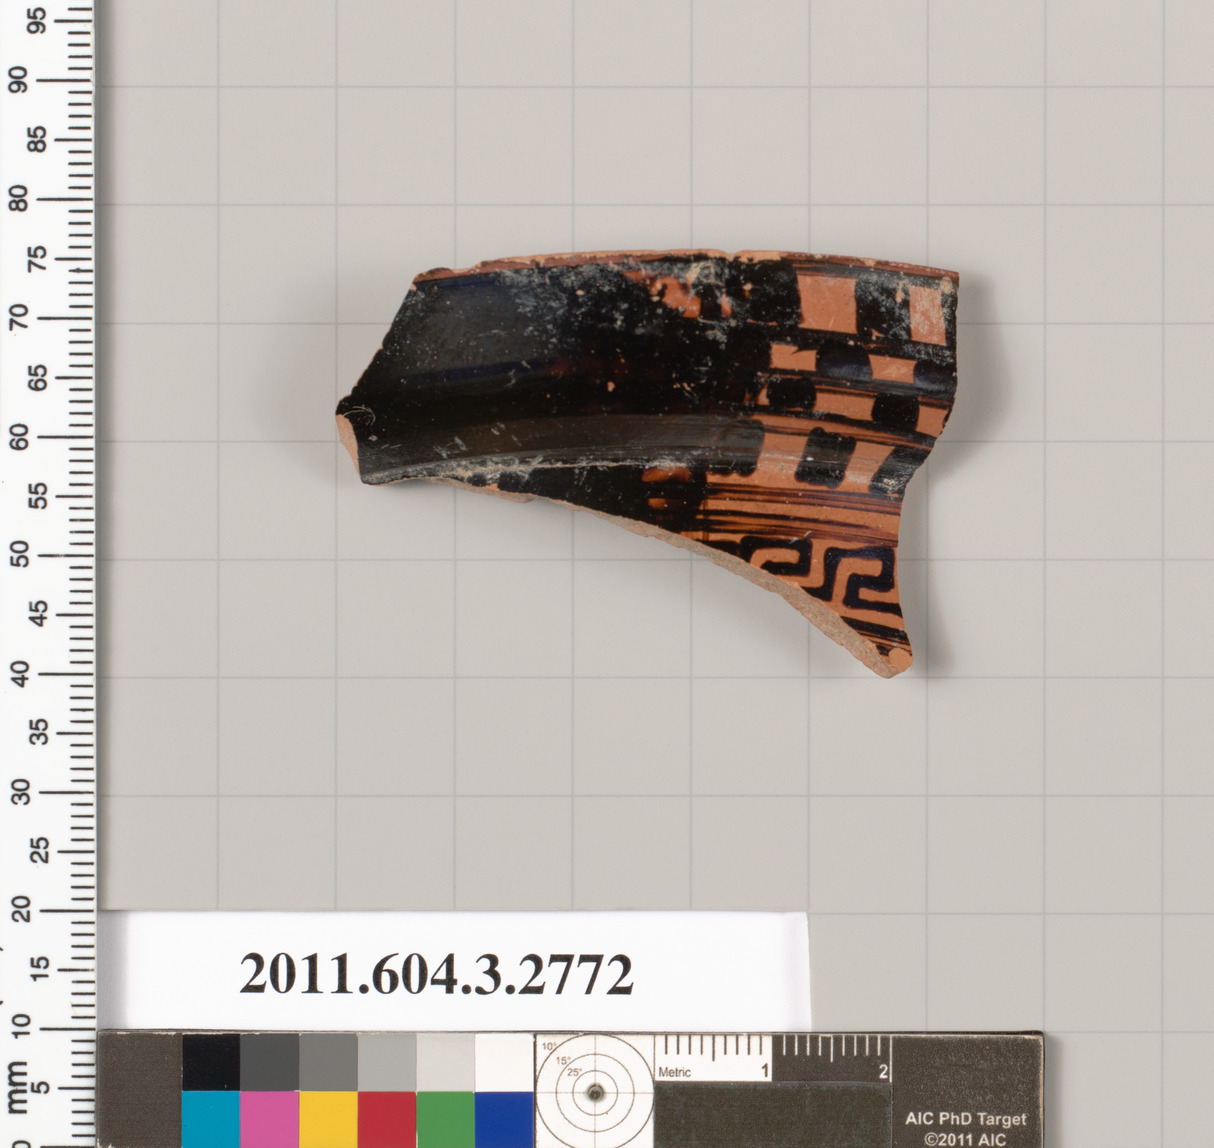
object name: olpe fragment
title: Terracotta fragment of an olpe (jug)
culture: greek, attic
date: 530-520 BCE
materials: terracotta